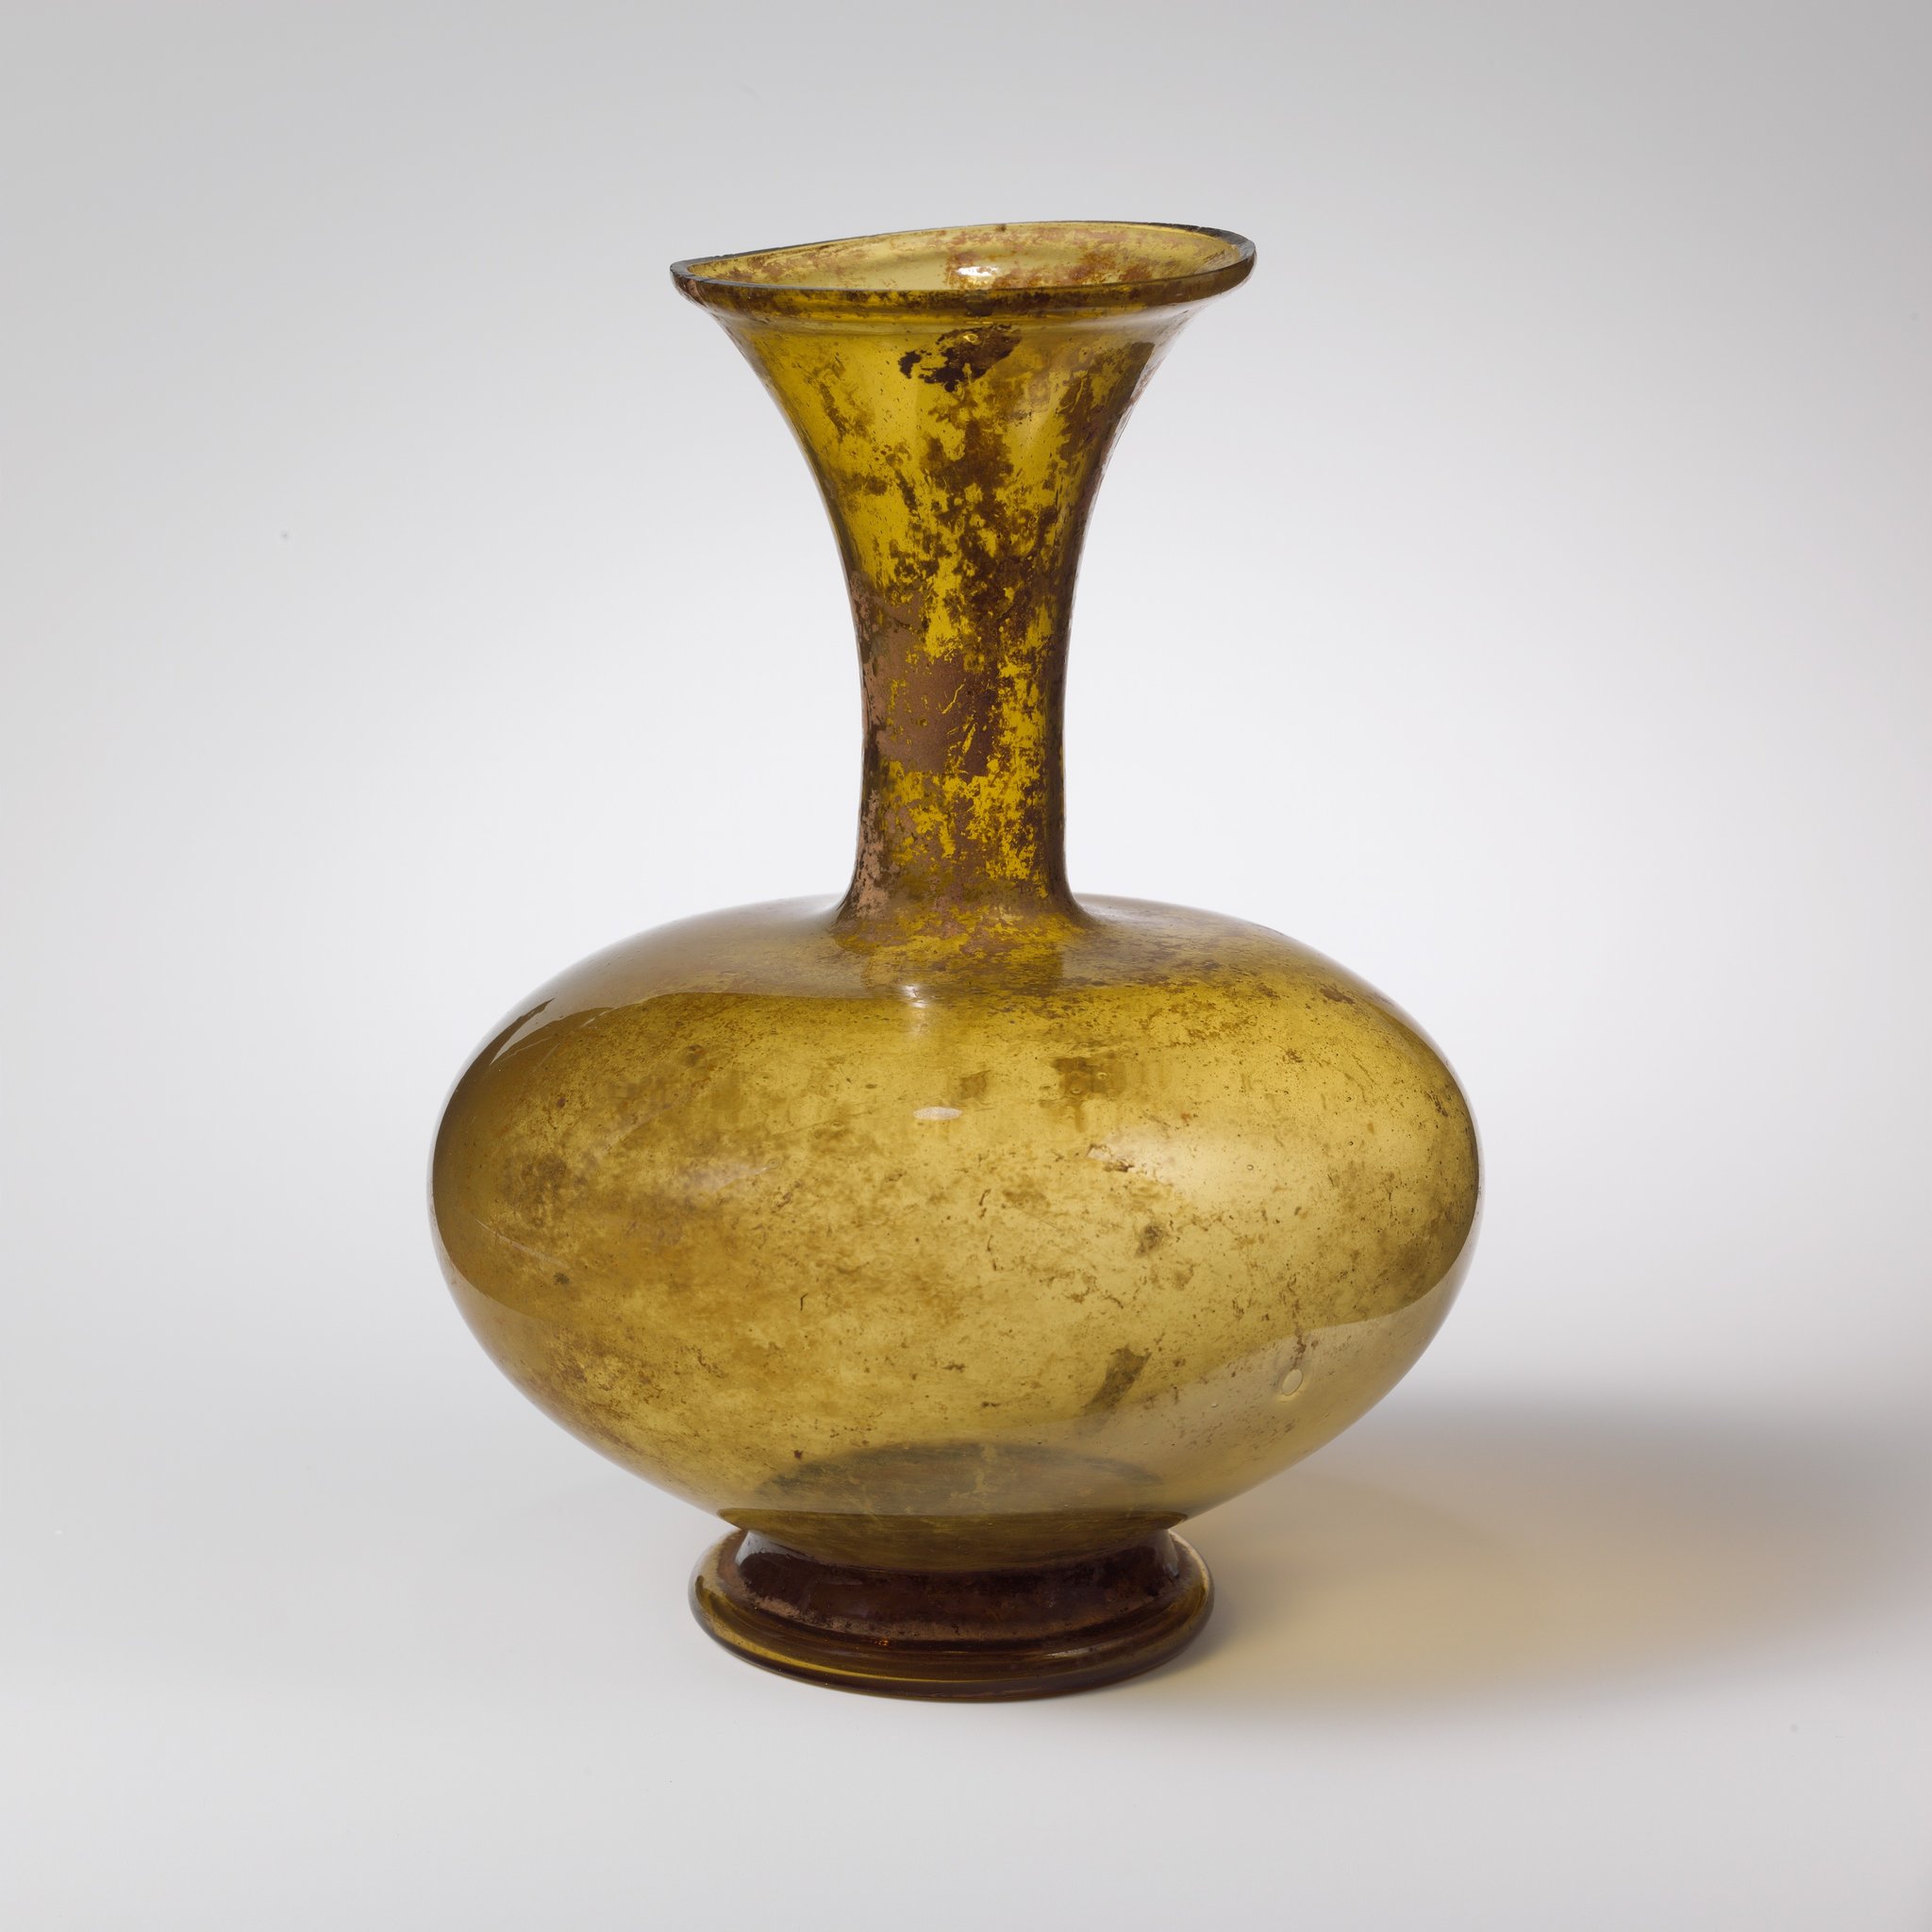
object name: bottle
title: Glass bottle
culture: roman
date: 301-500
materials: glass